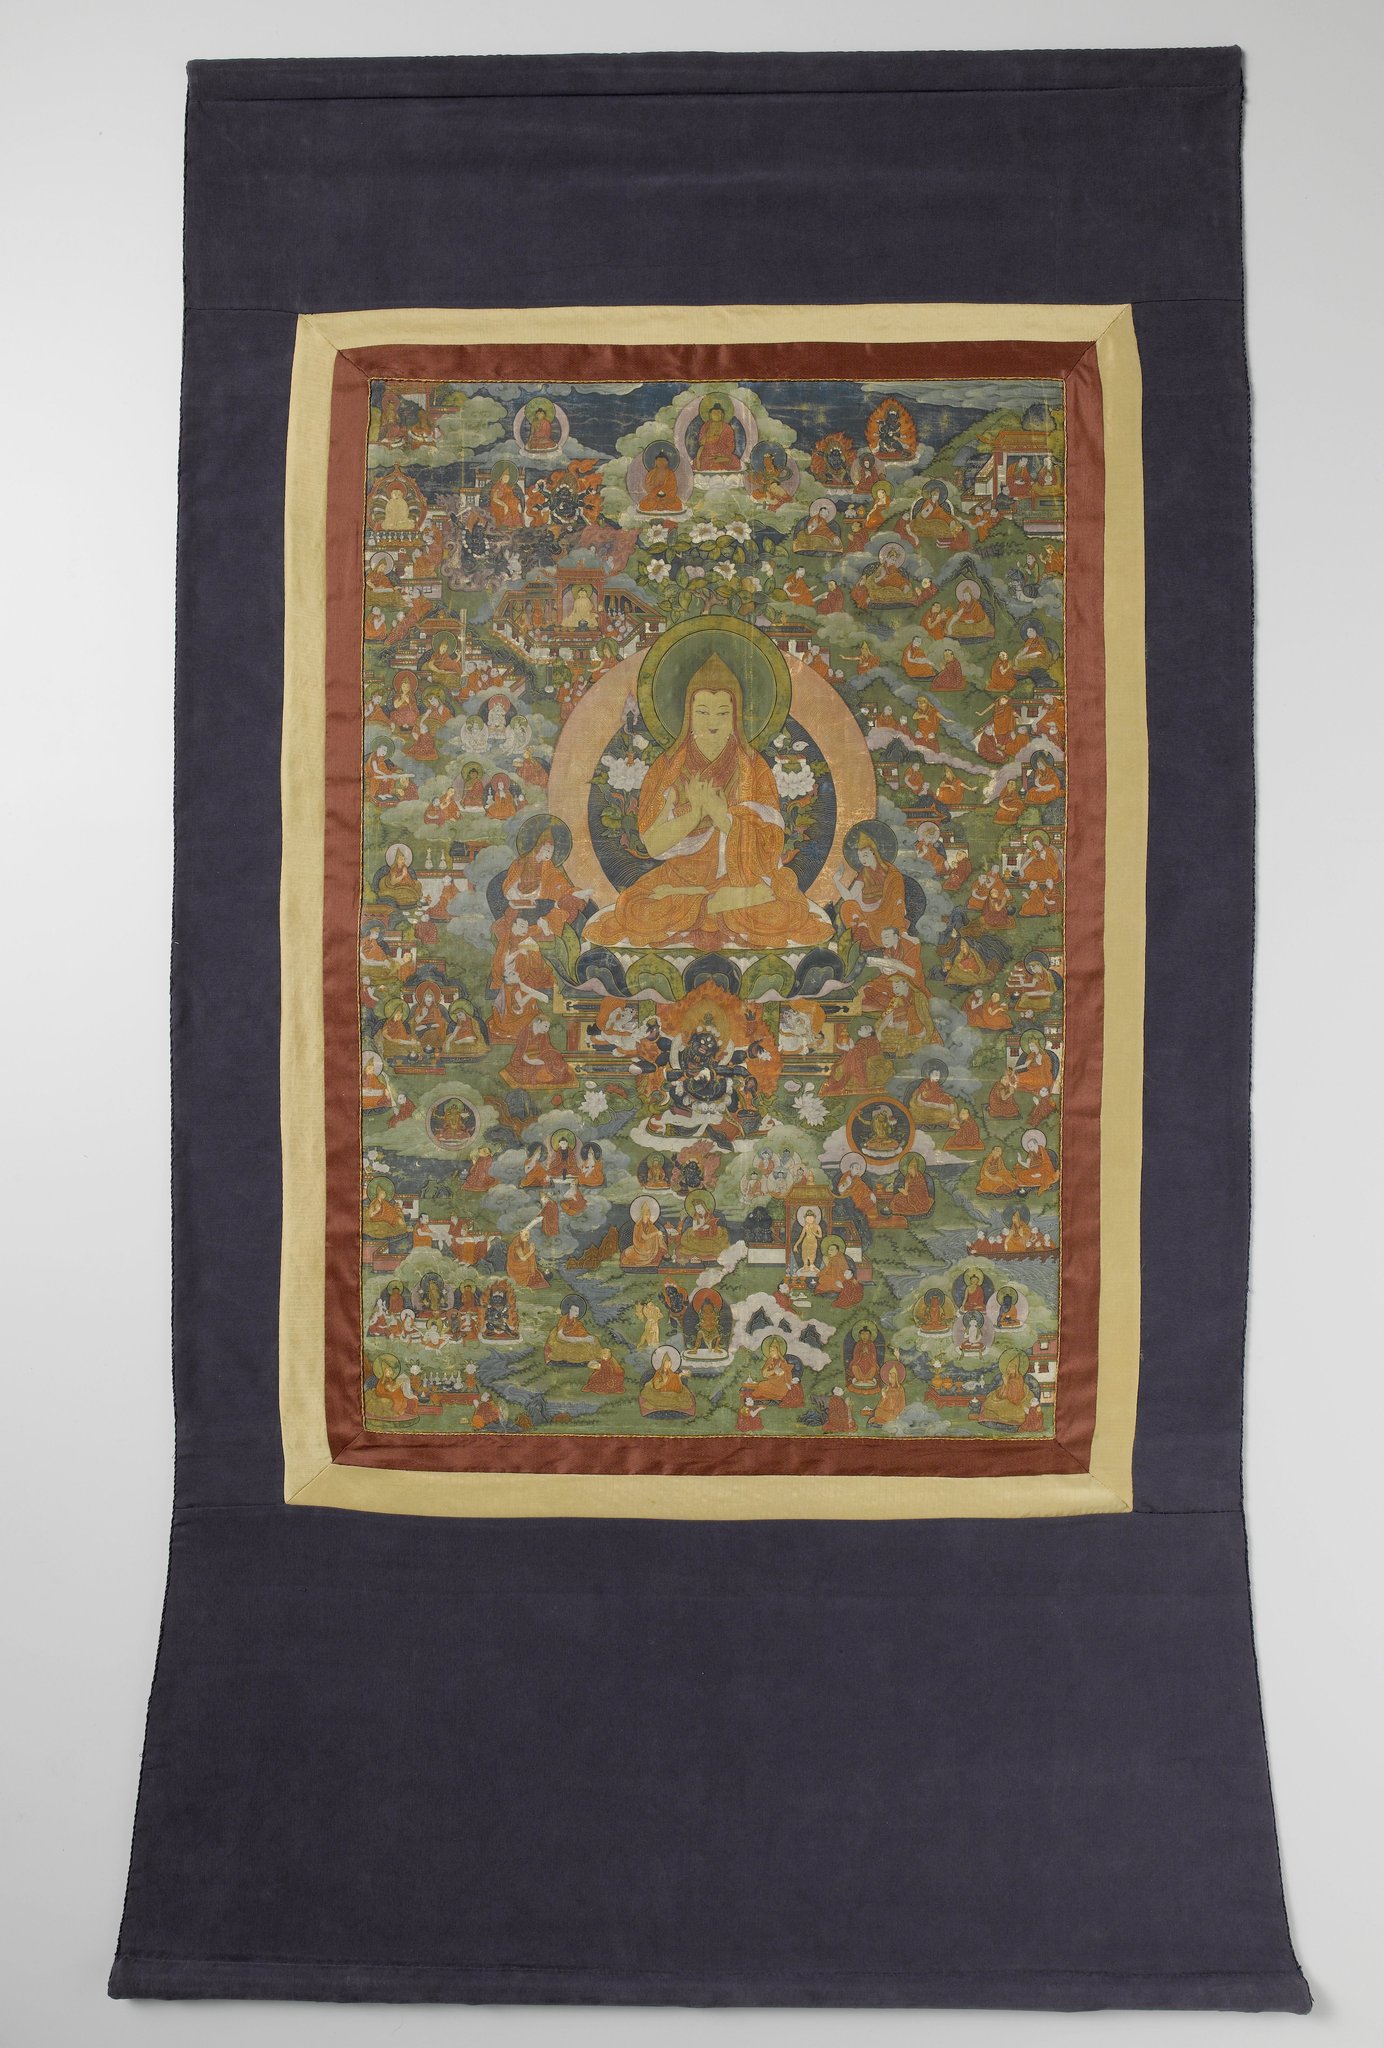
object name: tanka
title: Thang-ka, centrale figuur Tsong-kha-pa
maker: Anonymous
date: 1700-1800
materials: dye, linen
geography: tibet